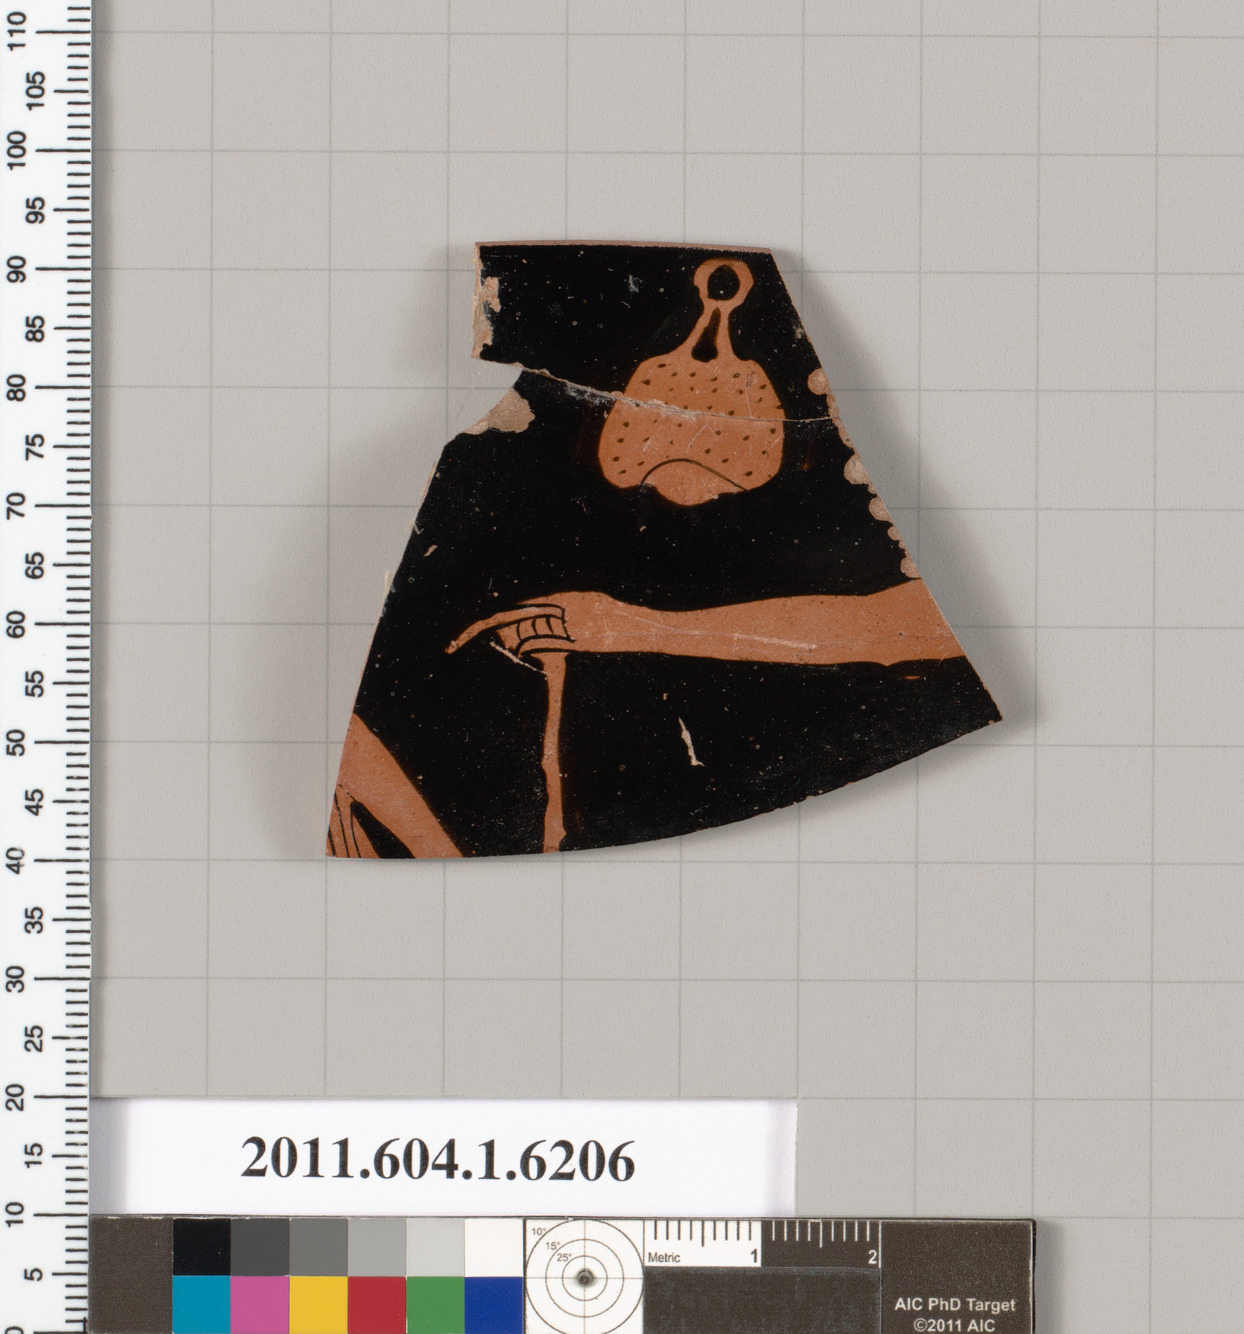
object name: kylix fragment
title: Terracotta rim fragment of a kylix (drinking cup)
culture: greek, attic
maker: painter of berlin 2268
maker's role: artist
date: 510-500 BCE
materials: terracotta